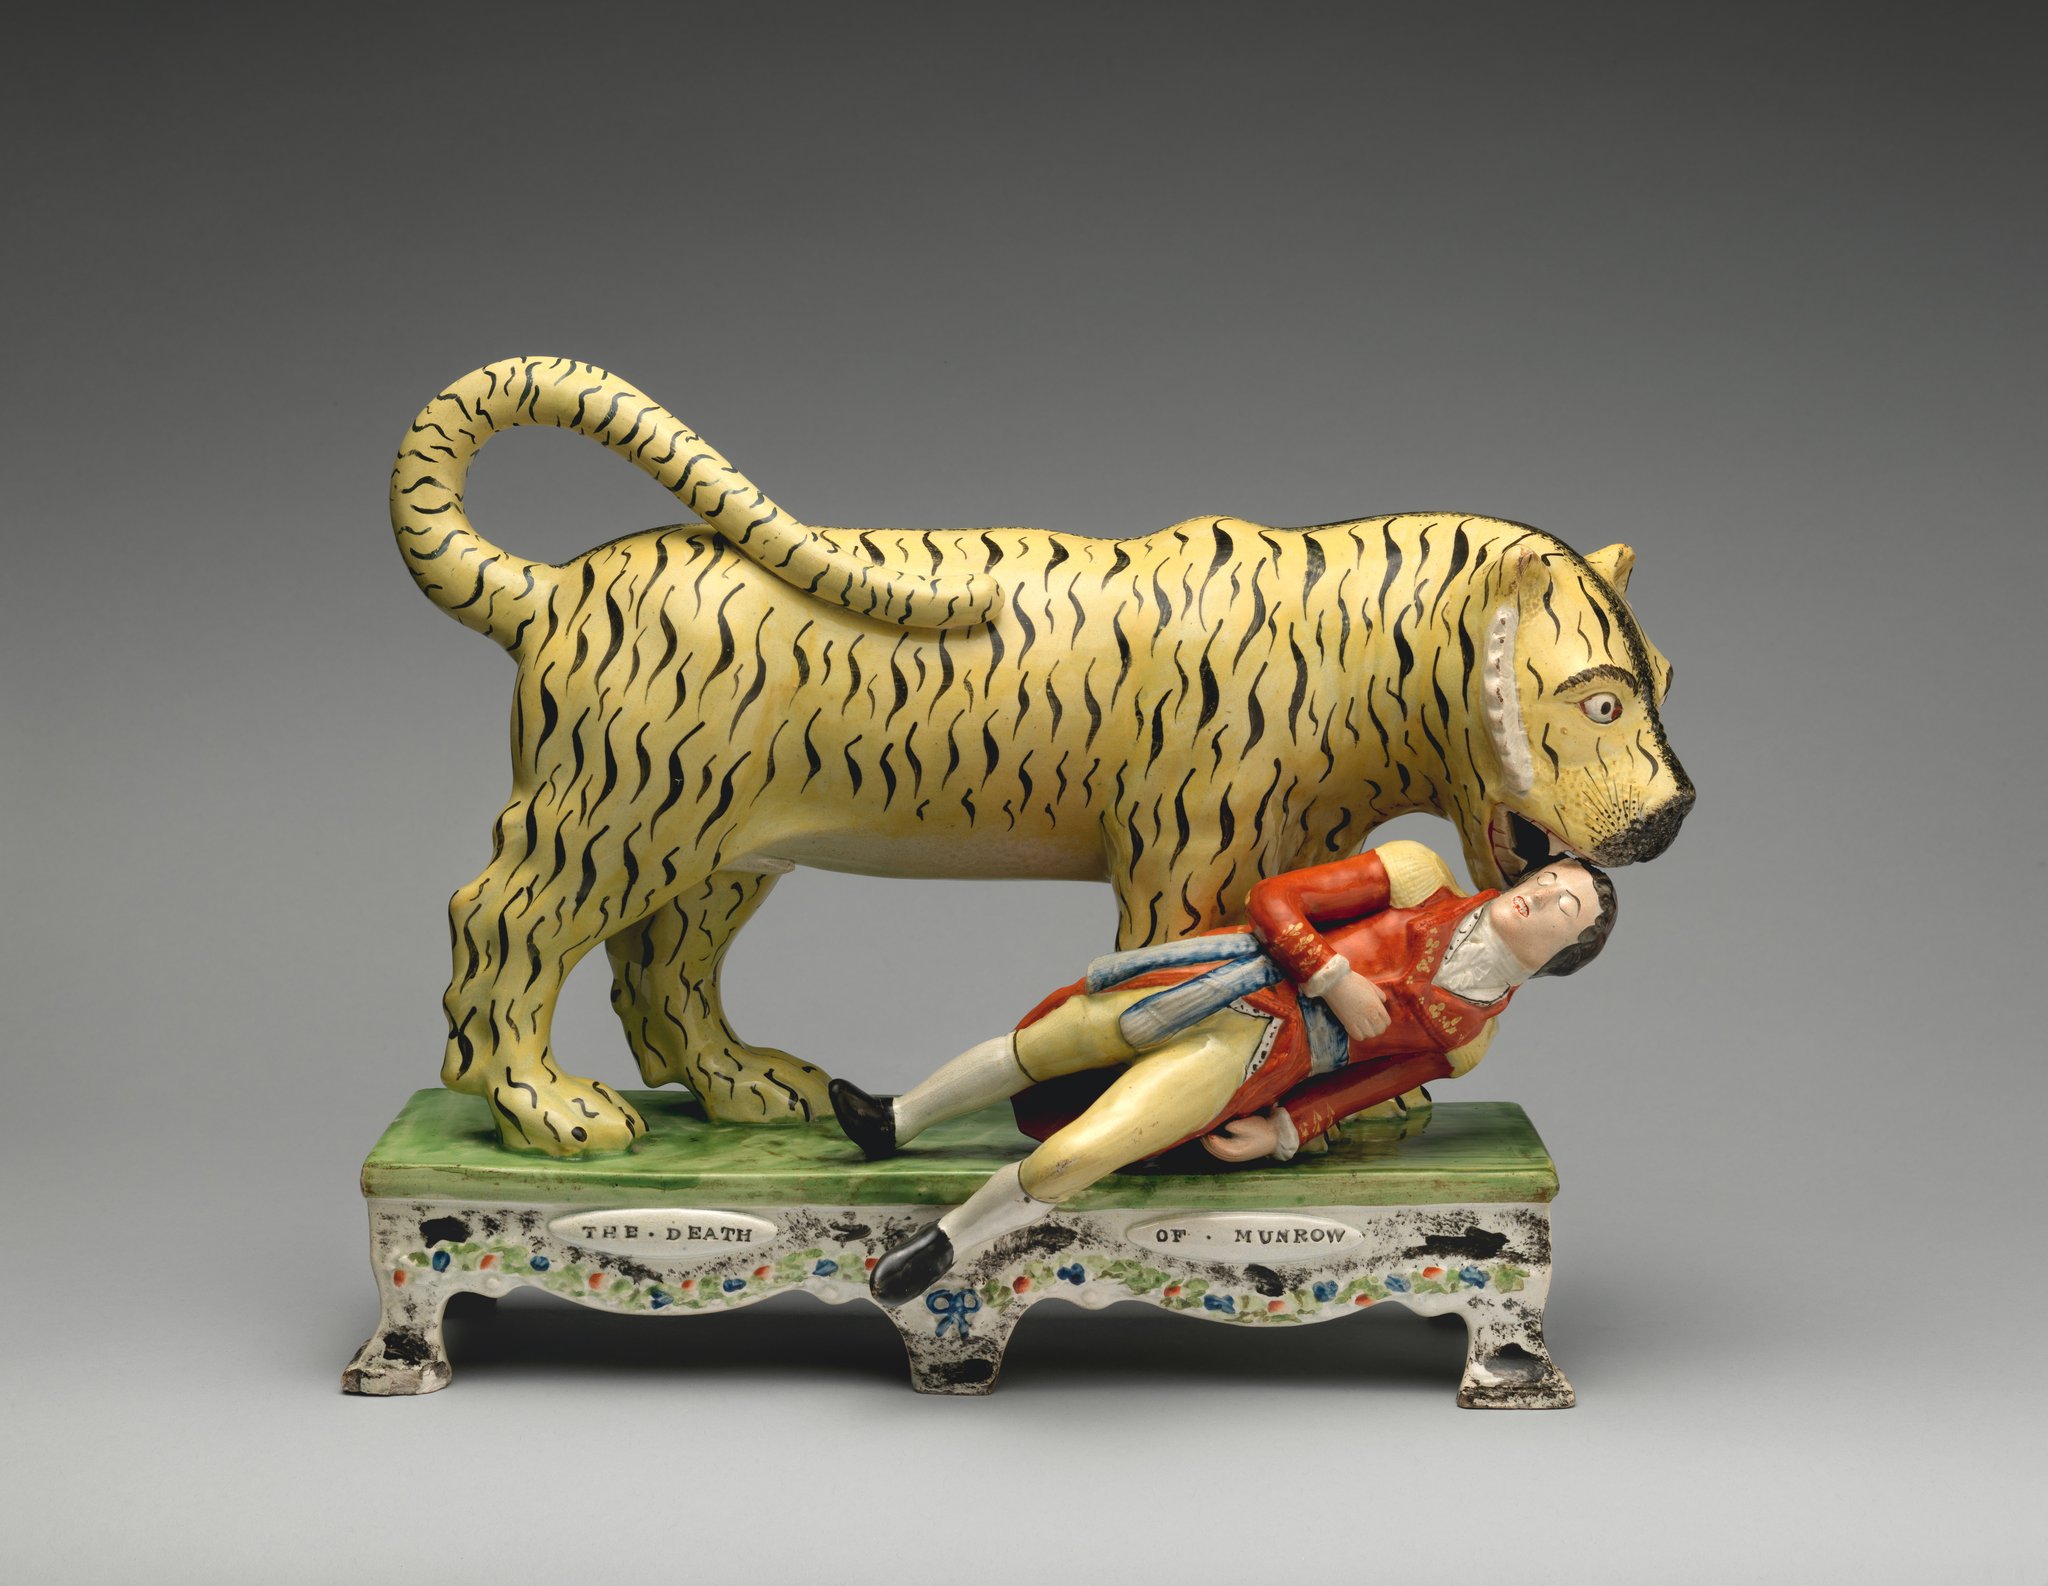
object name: figure group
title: The Death of Munrow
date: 1820-1830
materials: earthenware, enamel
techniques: glazing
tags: soldiers,men,tigers,death